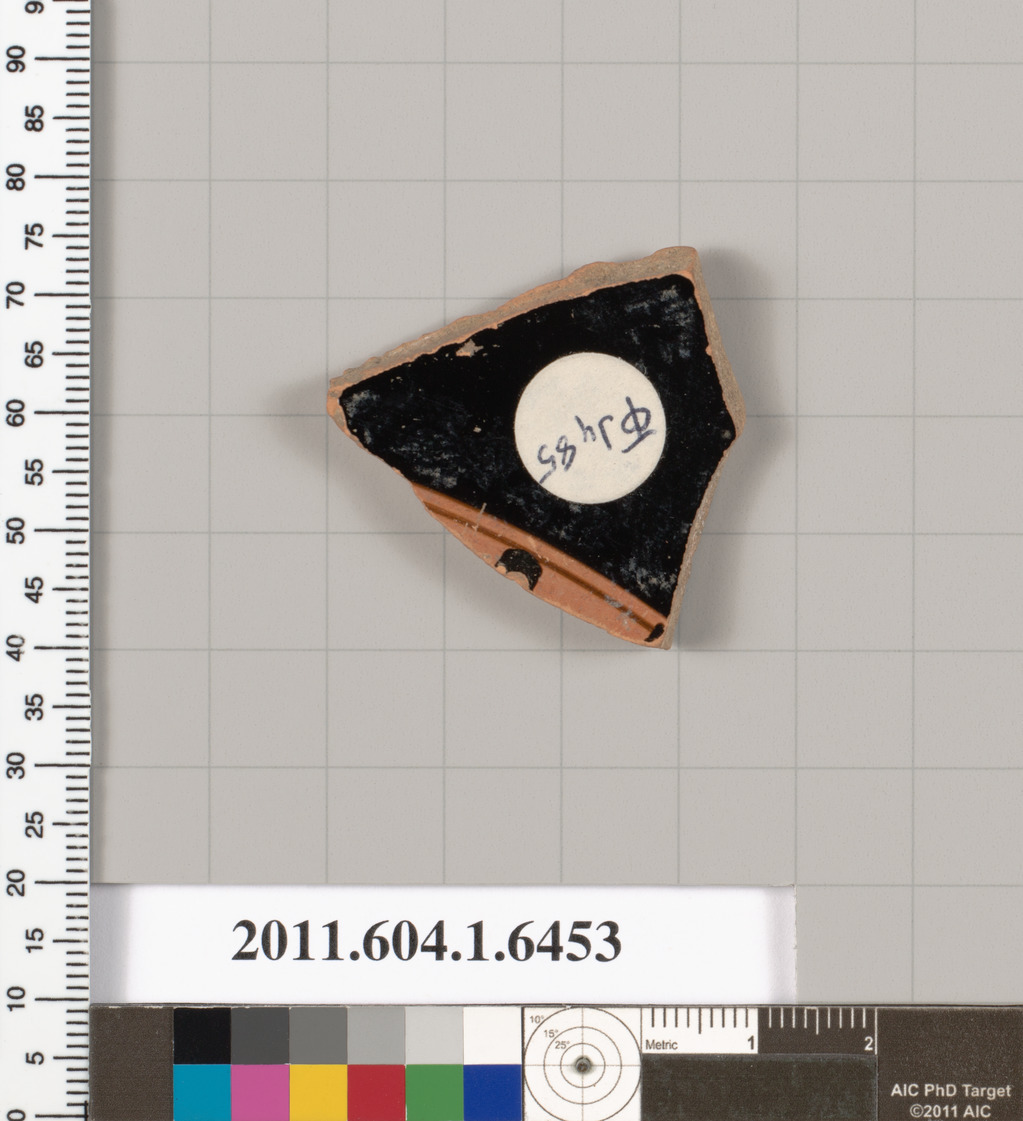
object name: kylix fragment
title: Terracotta fragment of a kylix (drinking cup)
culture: greek, attic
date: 490-480 BCE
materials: terracotta